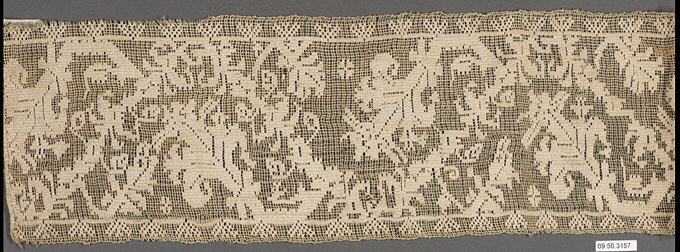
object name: strip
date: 1501-1600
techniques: embroidery